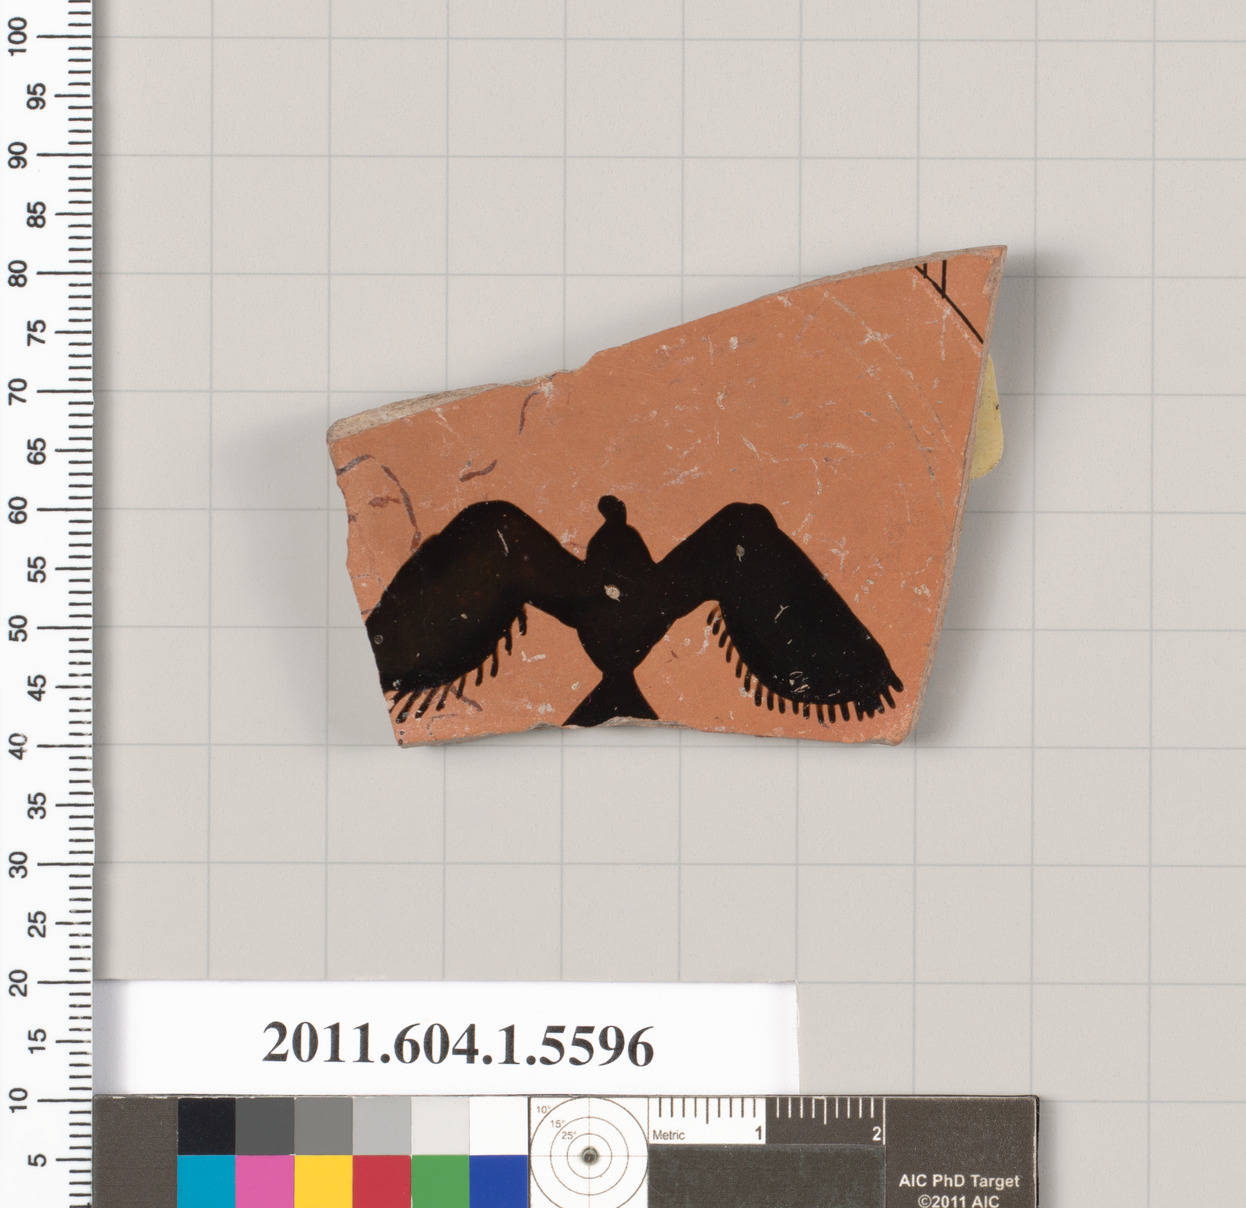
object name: kylix fragment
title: Terracotta fragment of a kylix (drinking cup)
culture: greek, attic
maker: foundry painter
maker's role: artist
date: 490-480 BCE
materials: terracotta